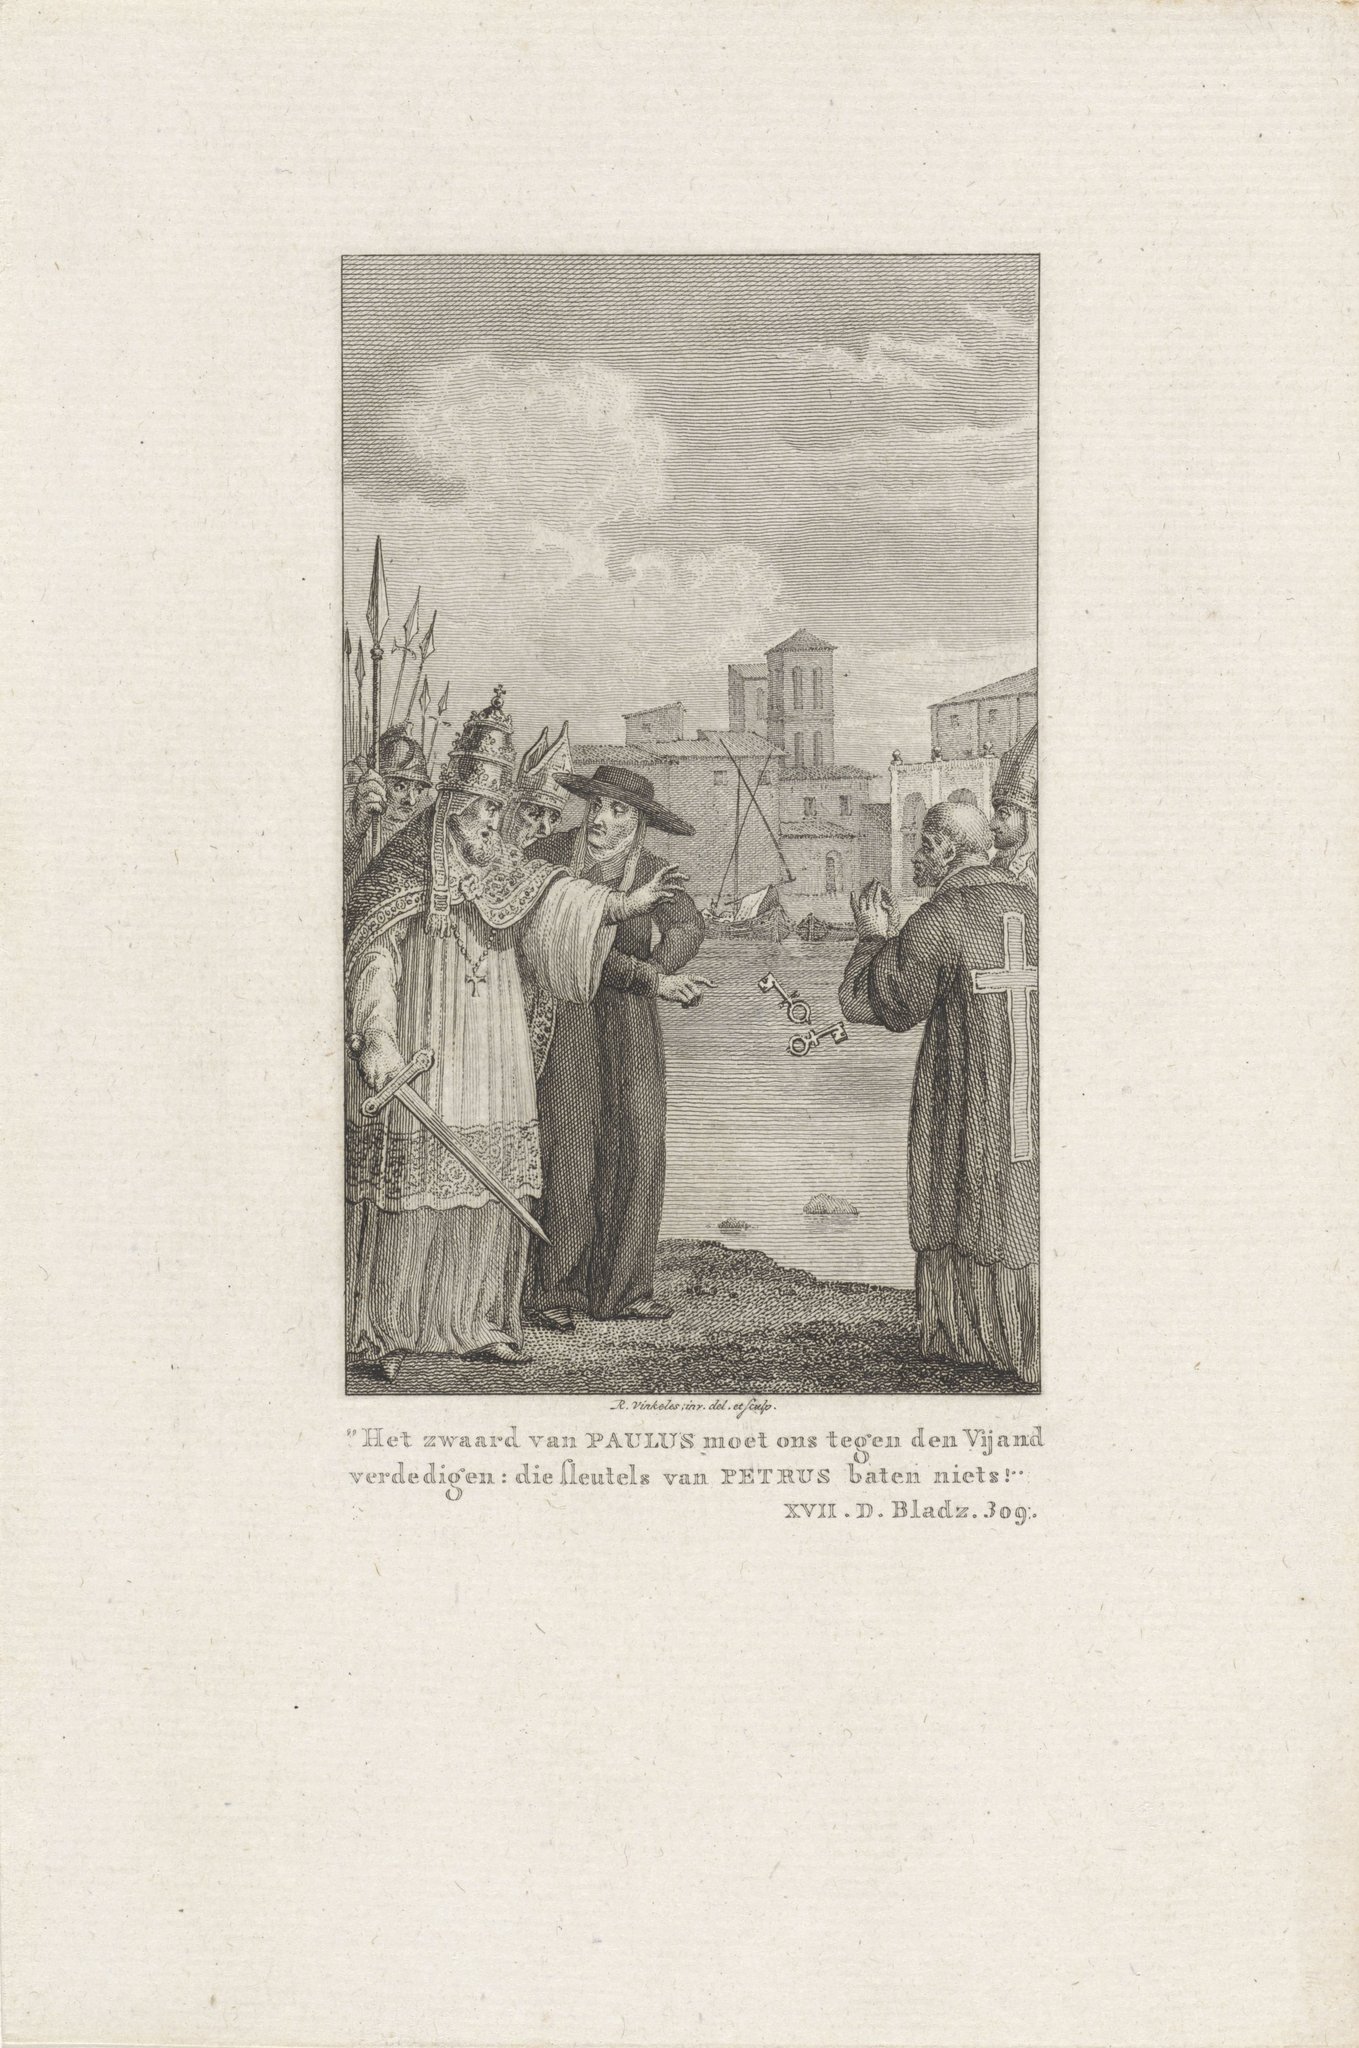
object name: print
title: Paus Julius II gooit de sleutels van Petrus in de Tiber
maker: reinier vinkeles (i)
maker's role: draughtsman, print maker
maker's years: 1741-1816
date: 1808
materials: paper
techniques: engraving, etching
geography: amsterdam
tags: key, hacking and thrusting weapons: sword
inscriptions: collector's mark: Lugt 2228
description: Paus Julius II, bijgenaamd 'il Terribile', verklaart dat de sleutels van Petrus waardeloos zijn en gooit ze in de Tiber. Hij voegt hieraan toe dat het zwaard van Paulus wel nuttig is.